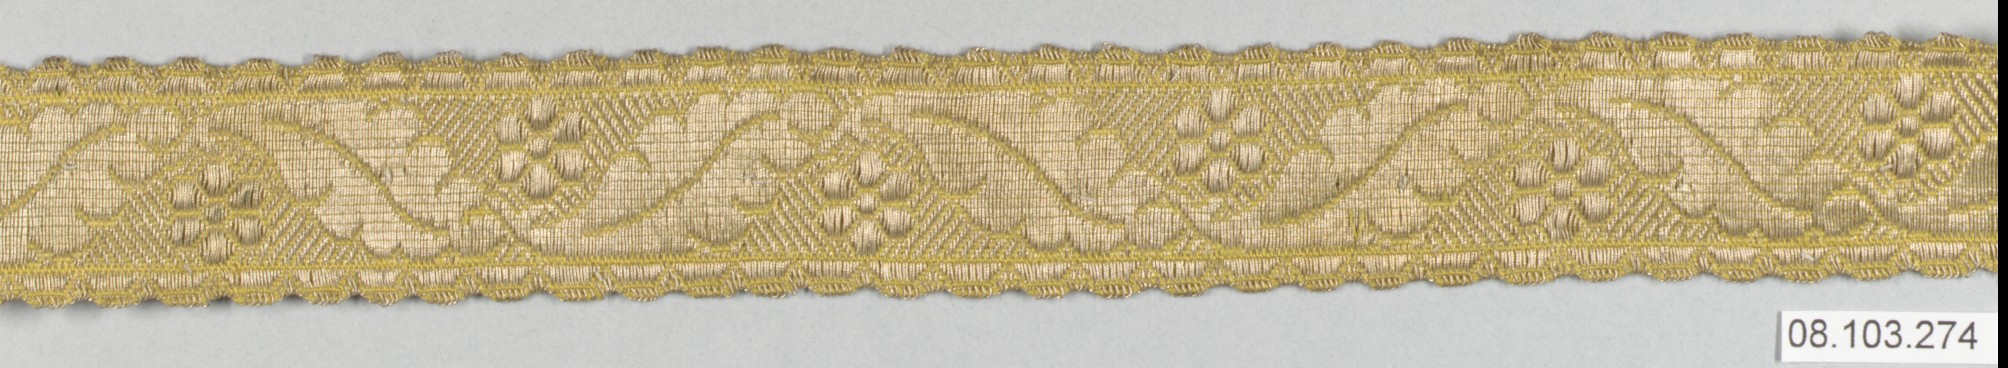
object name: galloon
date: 1601-1800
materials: metal thread, silk